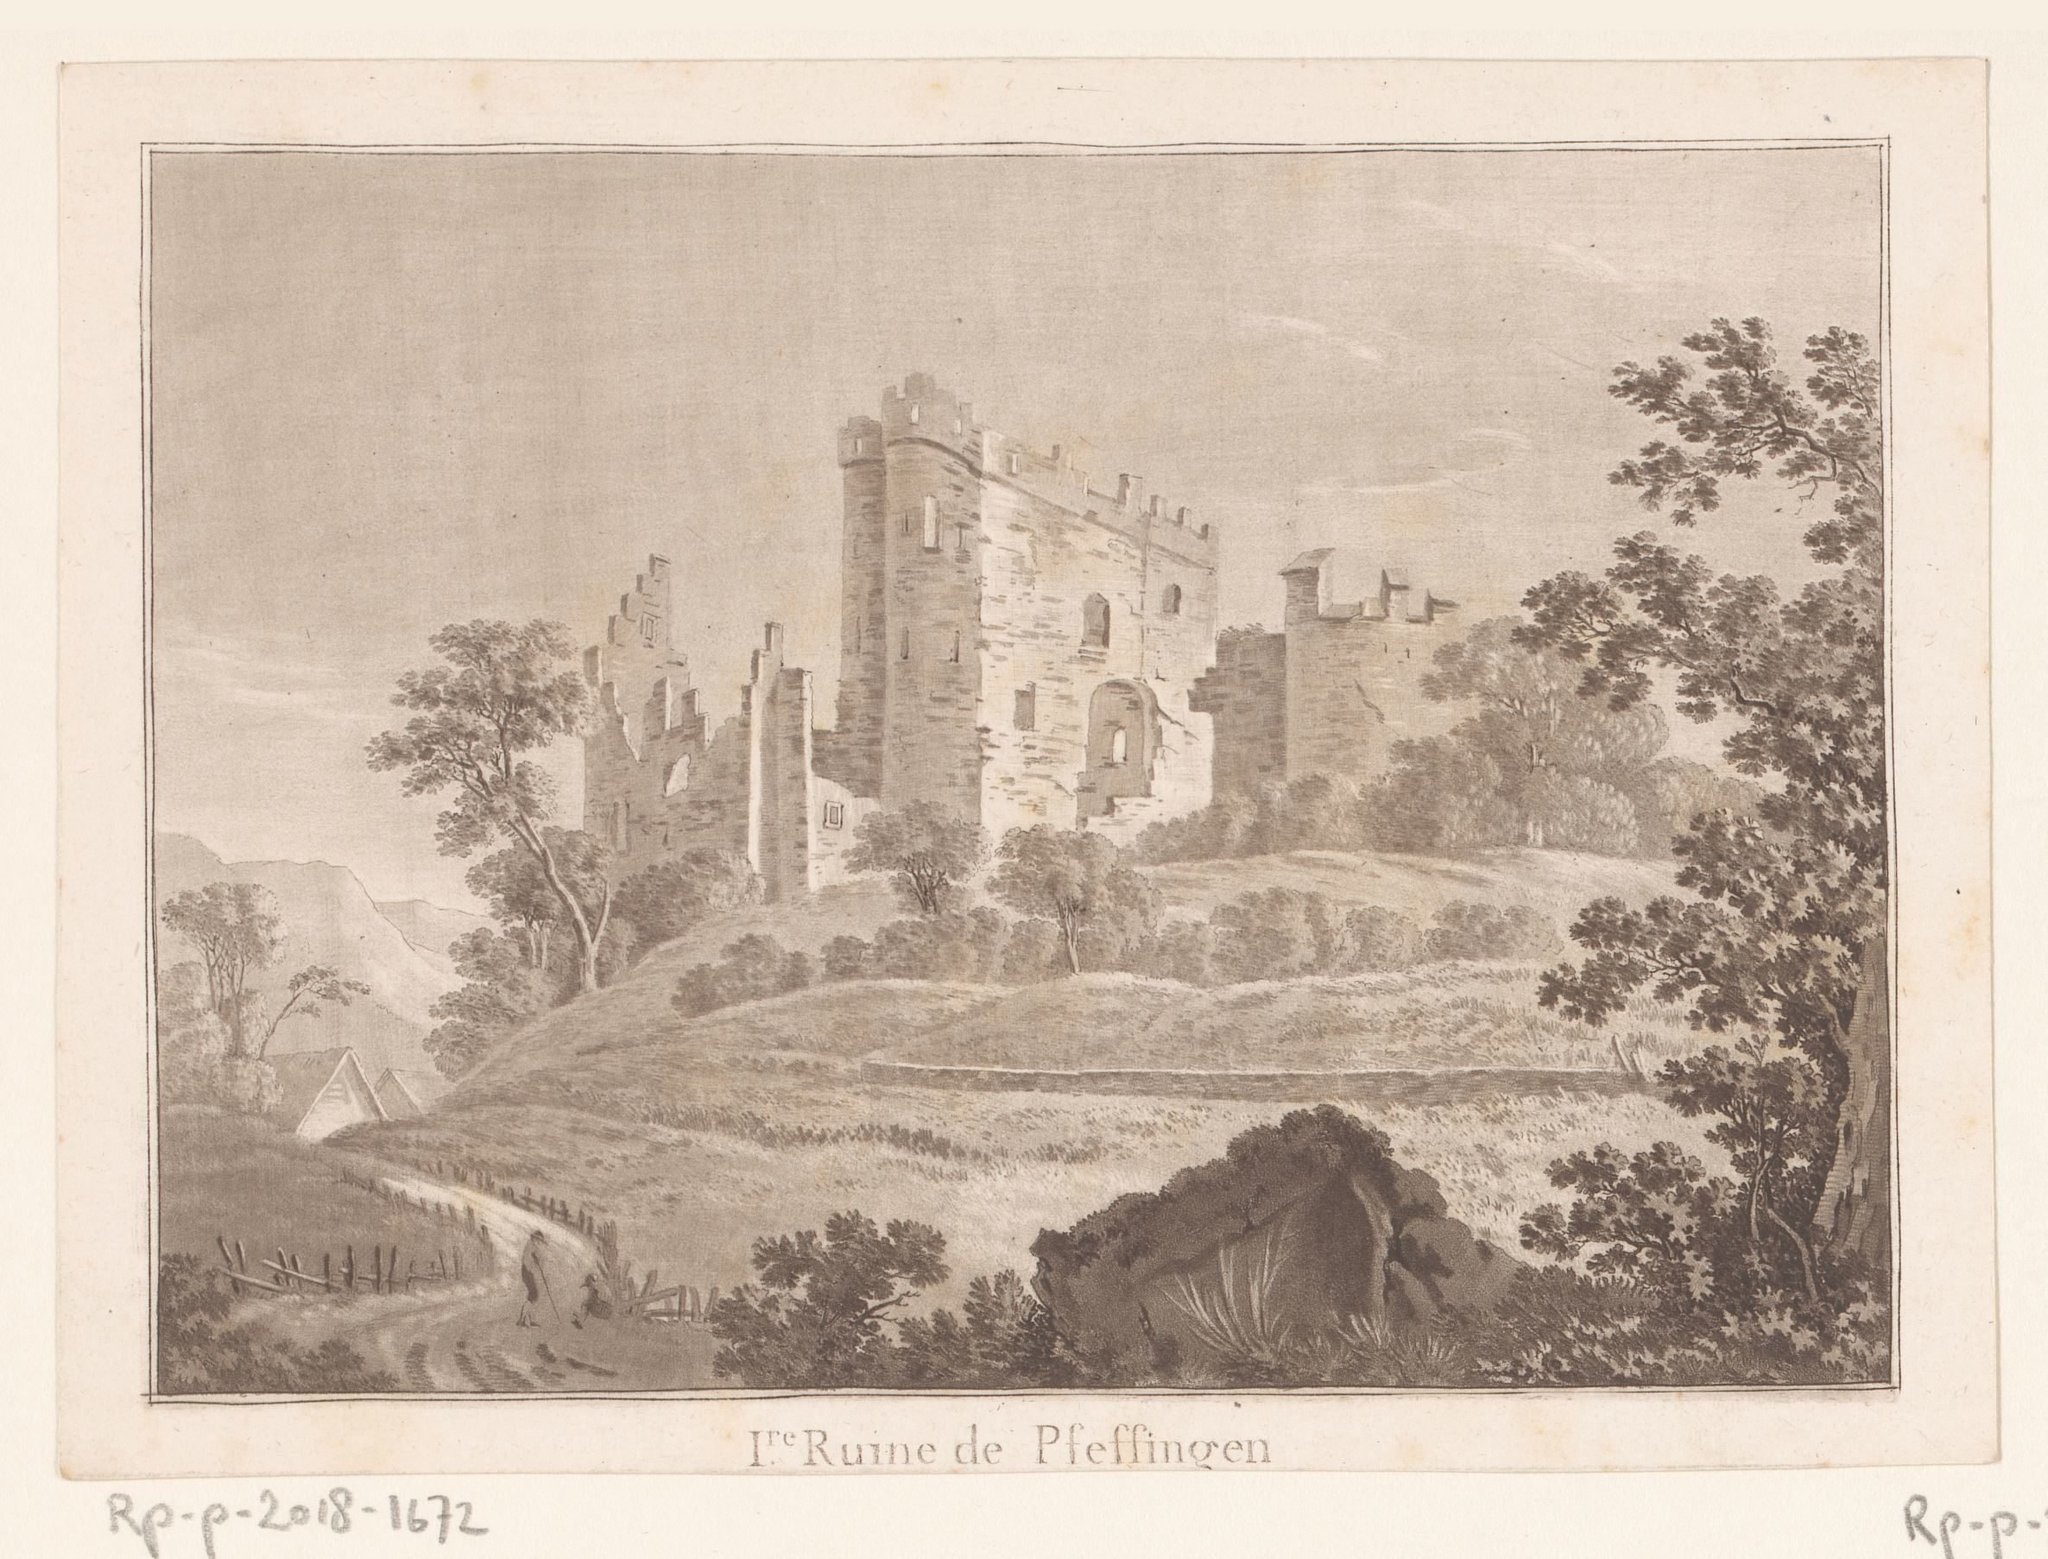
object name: print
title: 1re Ruine de Pfeffingen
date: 1810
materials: paper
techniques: aquatint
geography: amsterdam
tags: ruin of a dwelling, house, castle, etc.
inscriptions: collector's mark: Lugt 2228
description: Prent ook gebruikt in: Promenade Pittoresque dans l'évêché de bâle aux bords de la Birs (...). Amsterdam: T.B. Groebe, 1710.